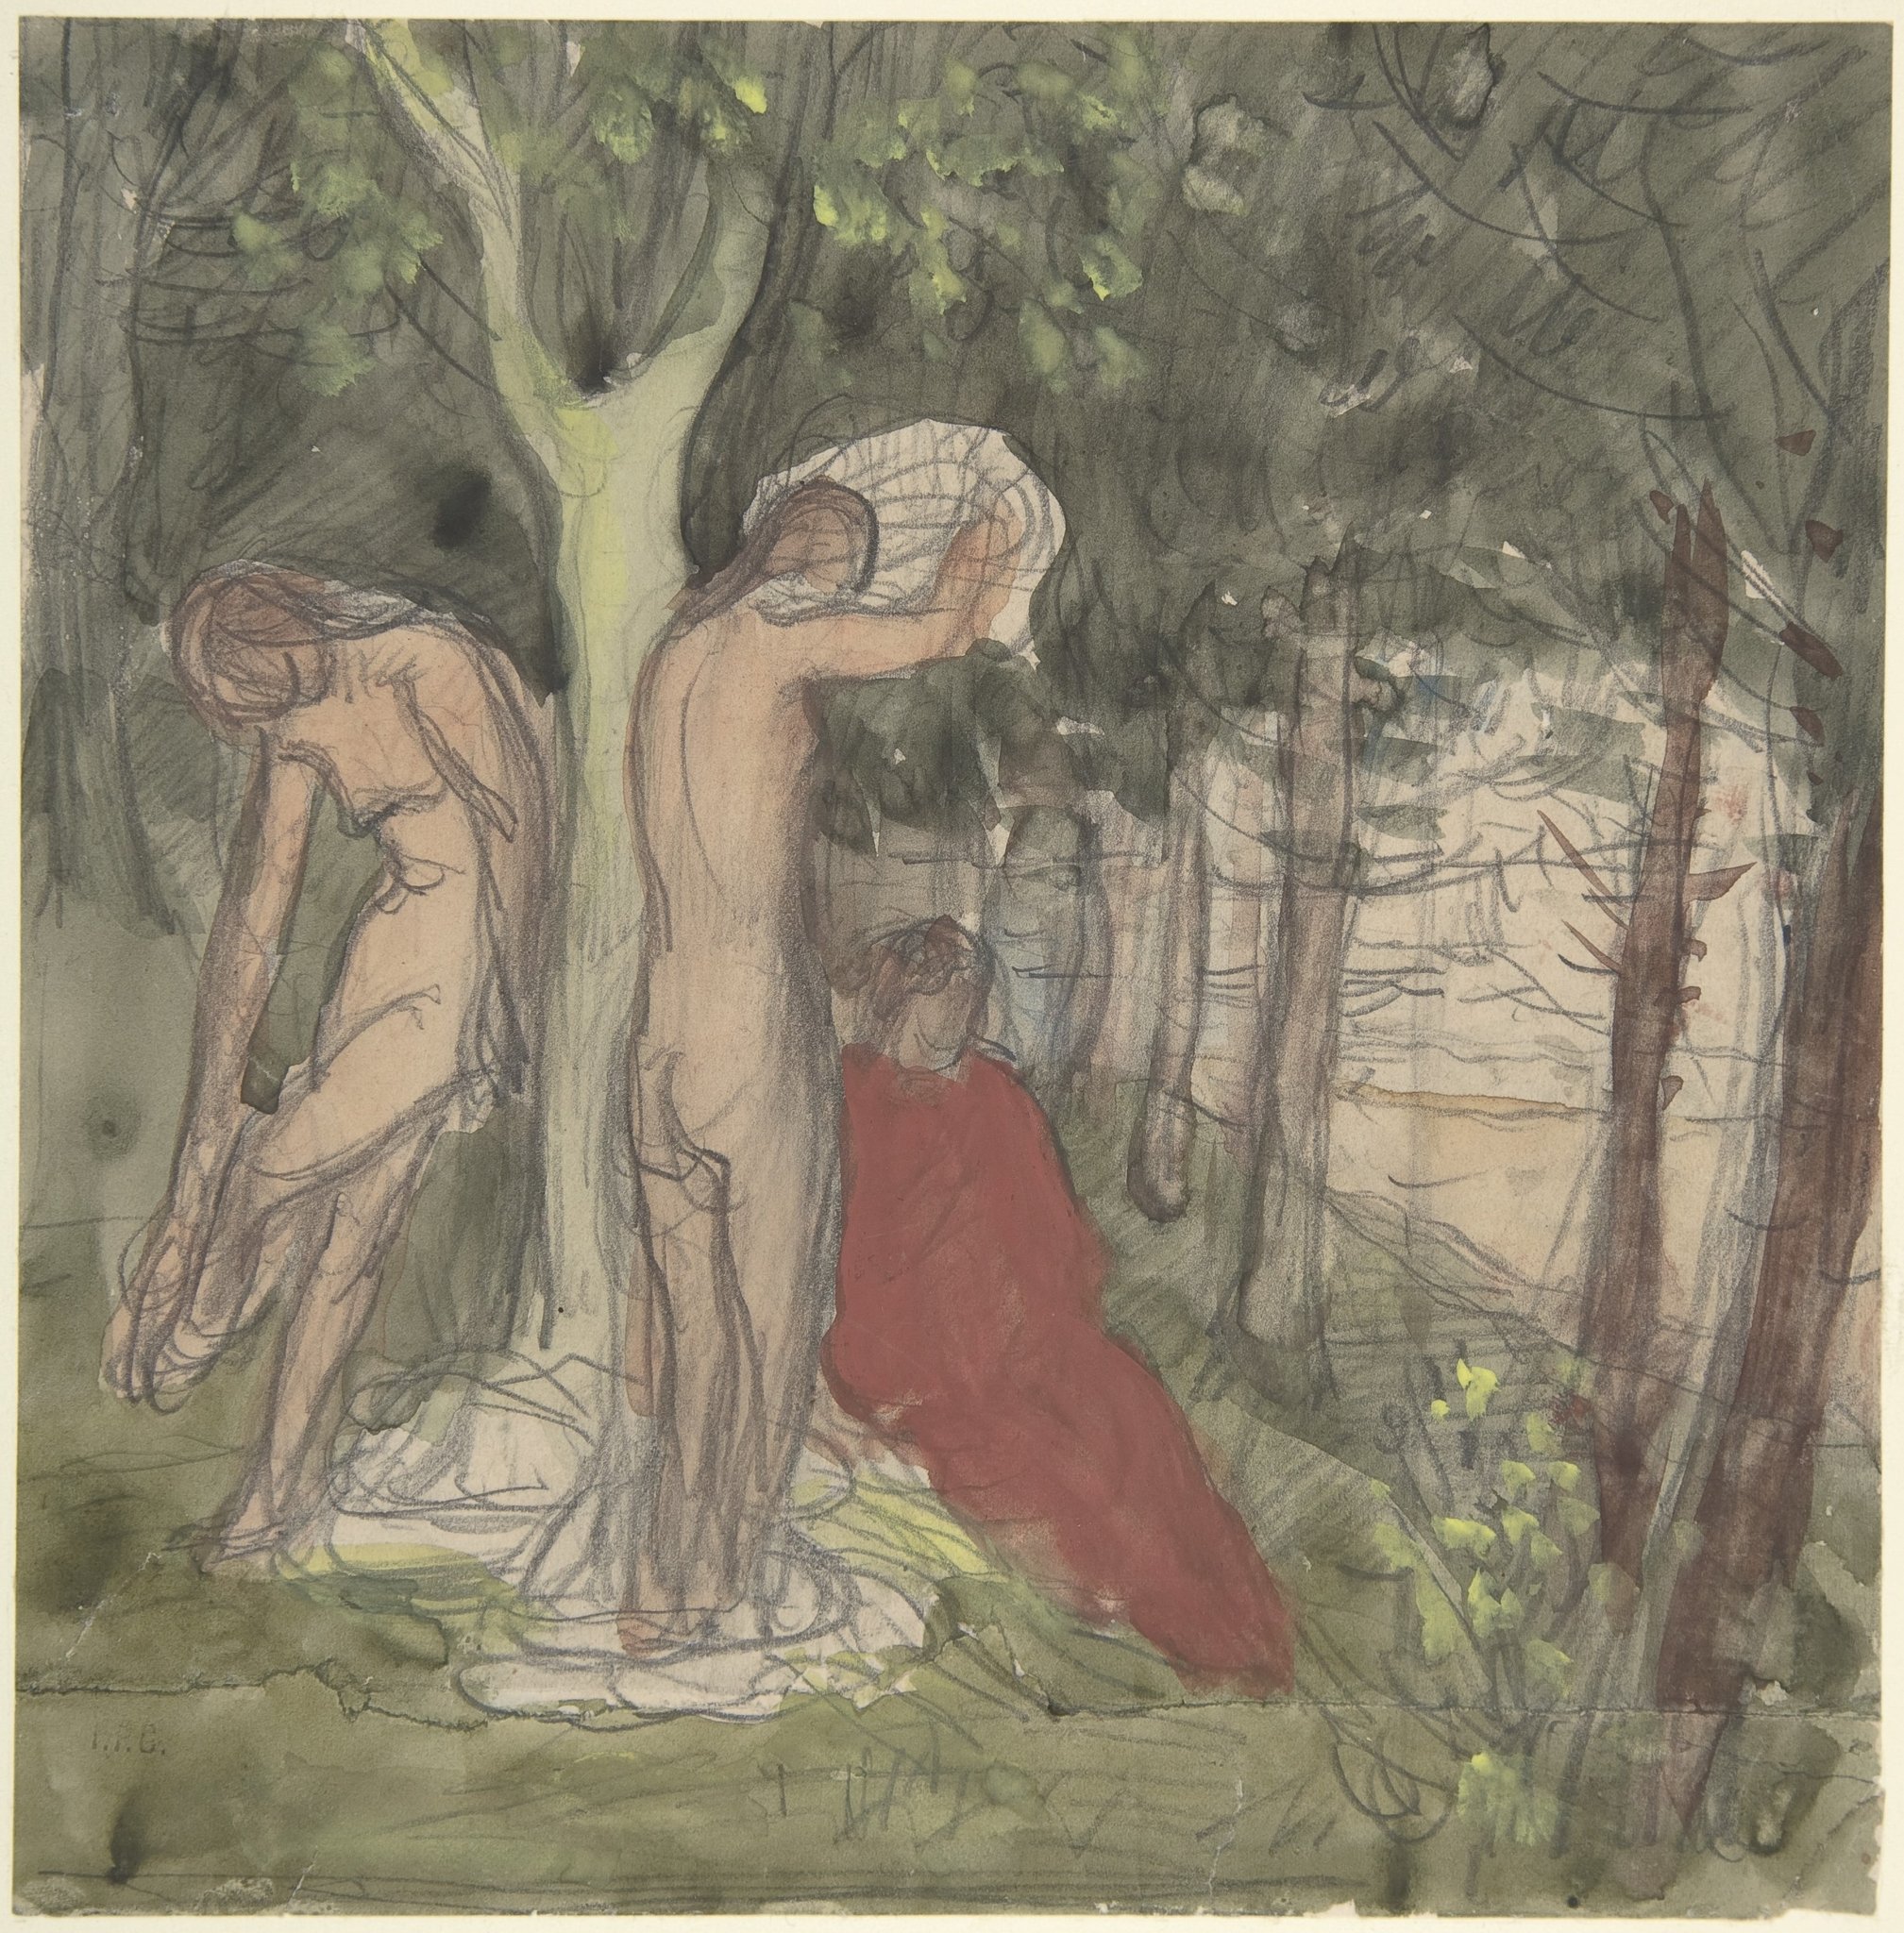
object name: drawing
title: Bathers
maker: pierre puvis de chavannes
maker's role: artist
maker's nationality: french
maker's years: 1824-1898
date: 1864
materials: graphite, watercolor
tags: female nudes,trees,bathing